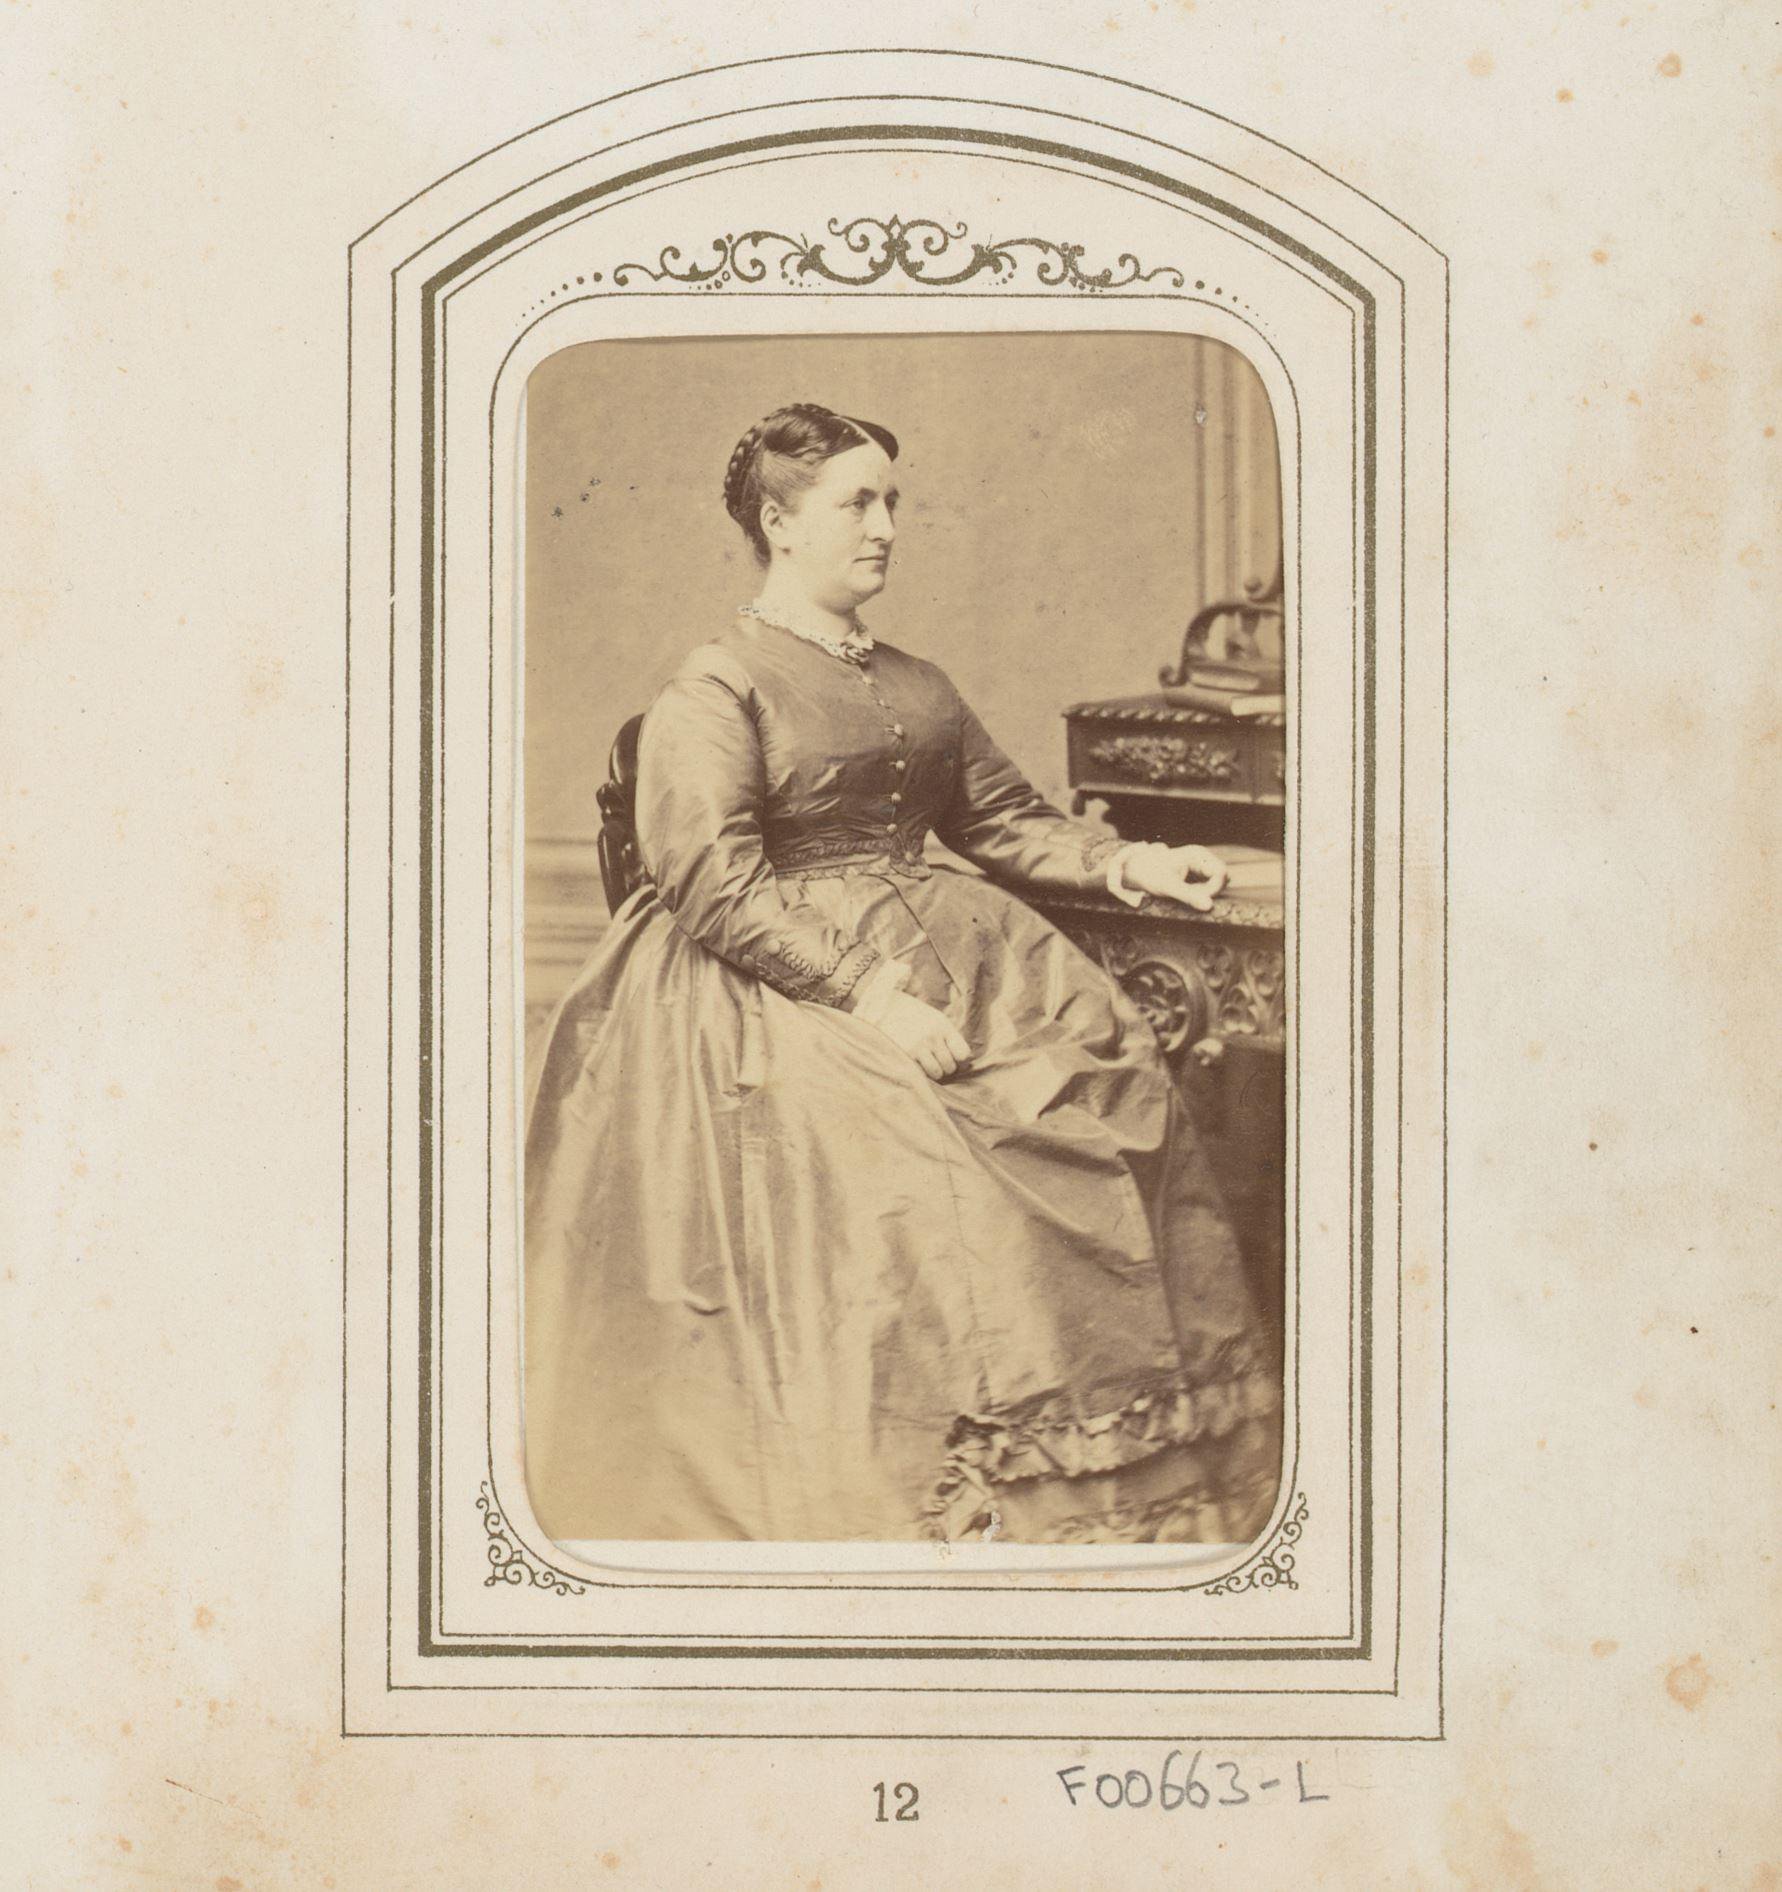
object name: album leaf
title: Portret van een zittende vrouw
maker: gerarda henriëtte matthijssen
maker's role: draughtsman, painter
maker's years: 1830-1907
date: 1860-1880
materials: cardboard, photographic support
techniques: albumen print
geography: leeuwarden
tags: historical persons - bb - woman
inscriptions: number: ‘12’, inscription: ‘Gerharda H. Matthijssen/ Photographe/ Leeuwarden/ Naauw H.46 en St. Jacobstraat H.50’